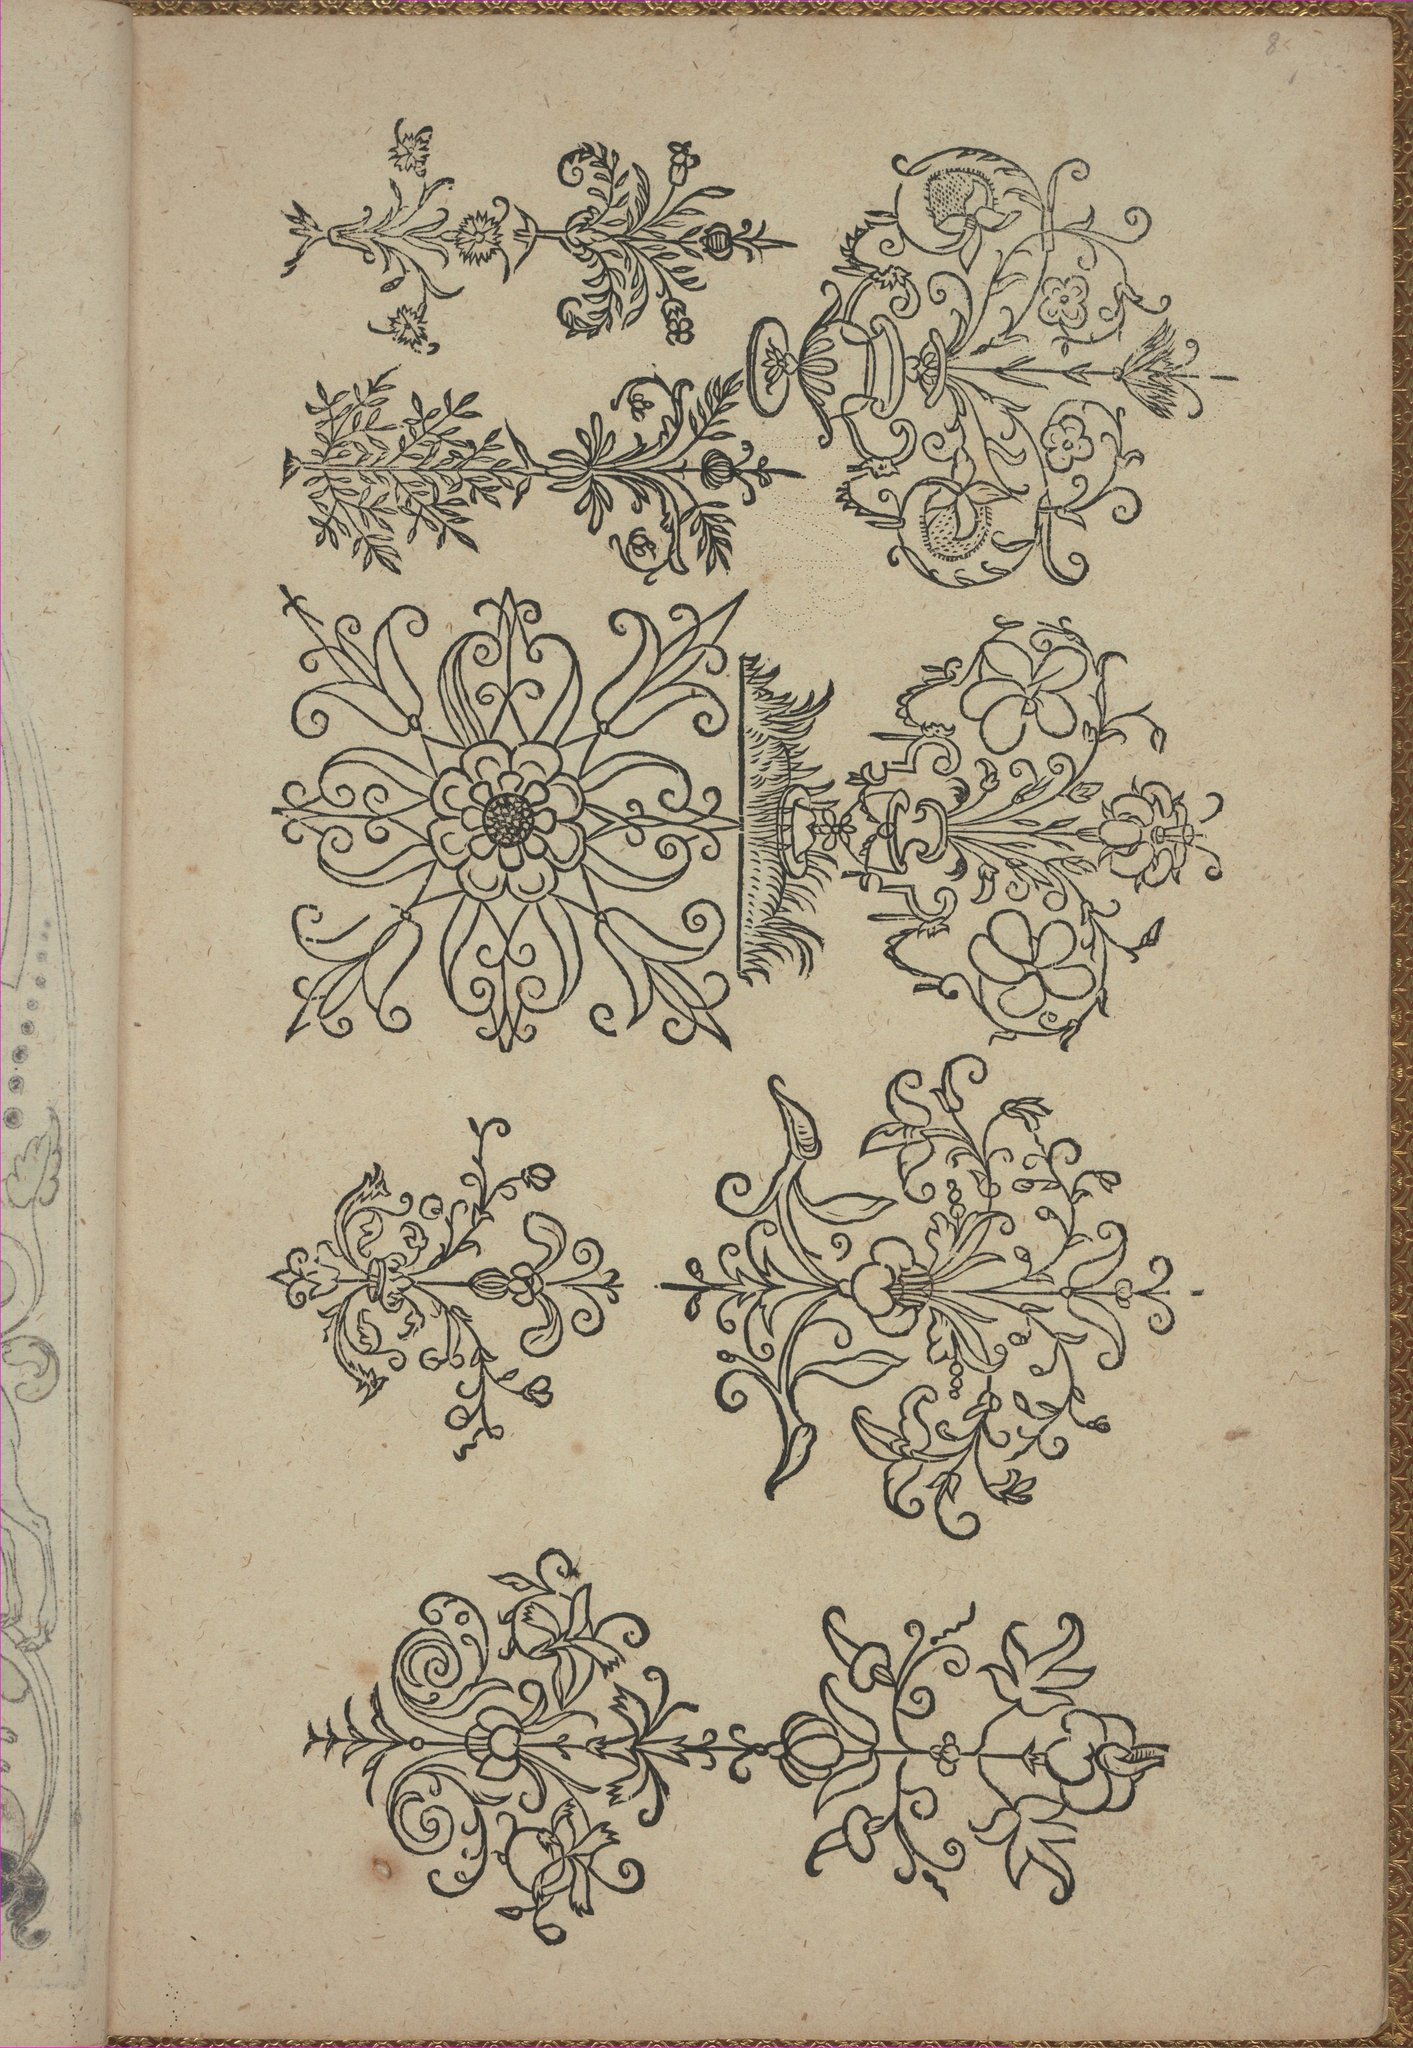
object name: book print ornament architecture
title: New Modelbüch (Page 8r)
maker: andreas bretschneider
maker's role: designer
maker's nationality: german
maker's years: 1573-1645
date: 1615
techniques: woodcut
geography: germany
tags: flowers